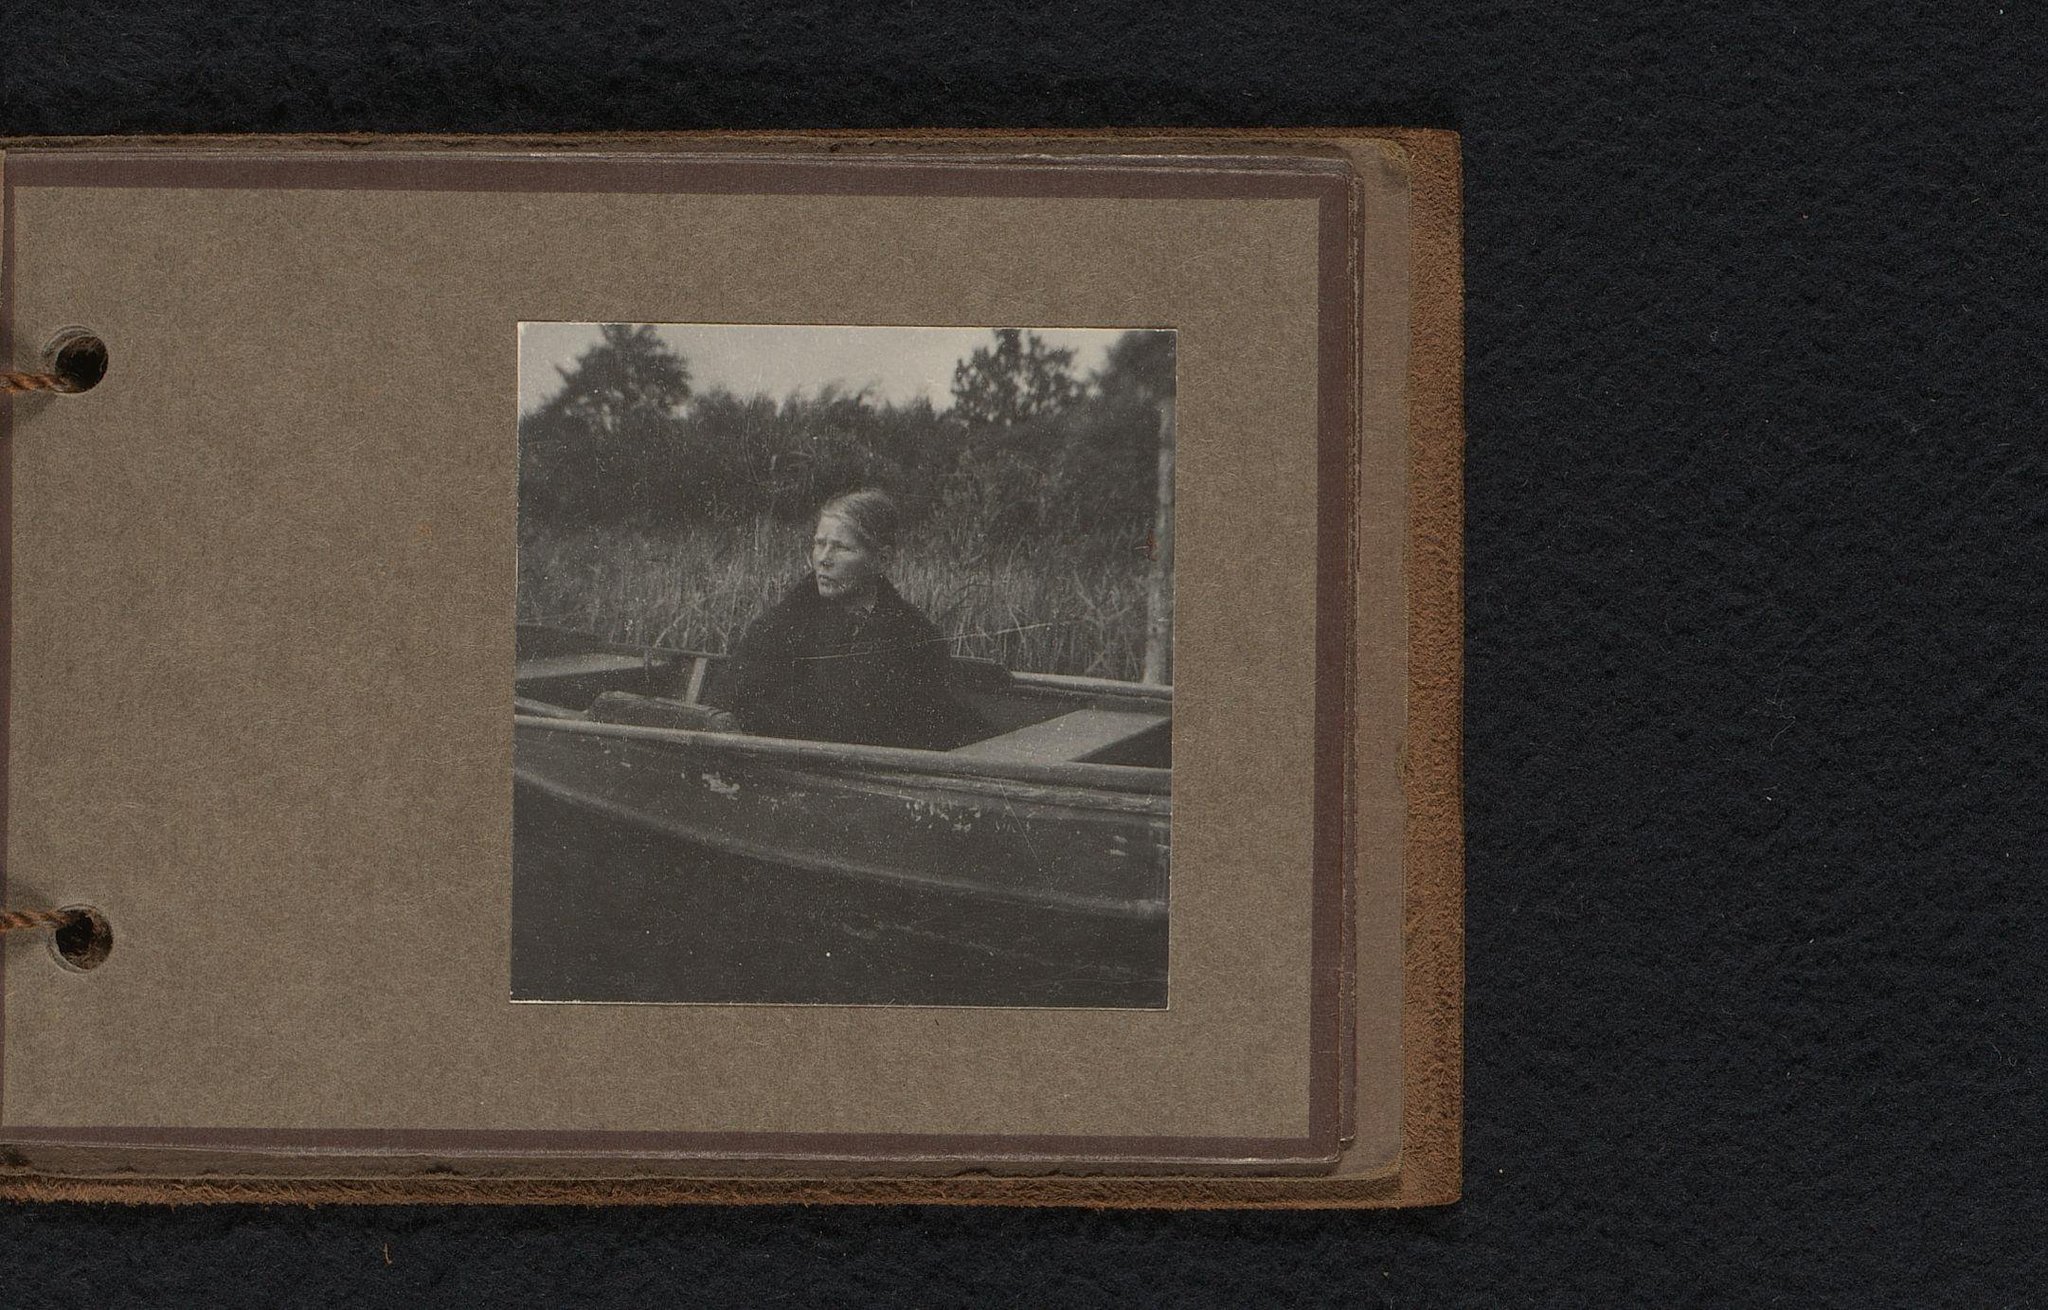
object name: photograph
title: Portret van een vrouw in een roeiboot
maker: Anonymous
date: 1900-1930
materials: paper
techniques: gelatin silver print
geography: netherlands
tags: historical persons not known by name - bb - woman, rowing-boat, canoe, etc.